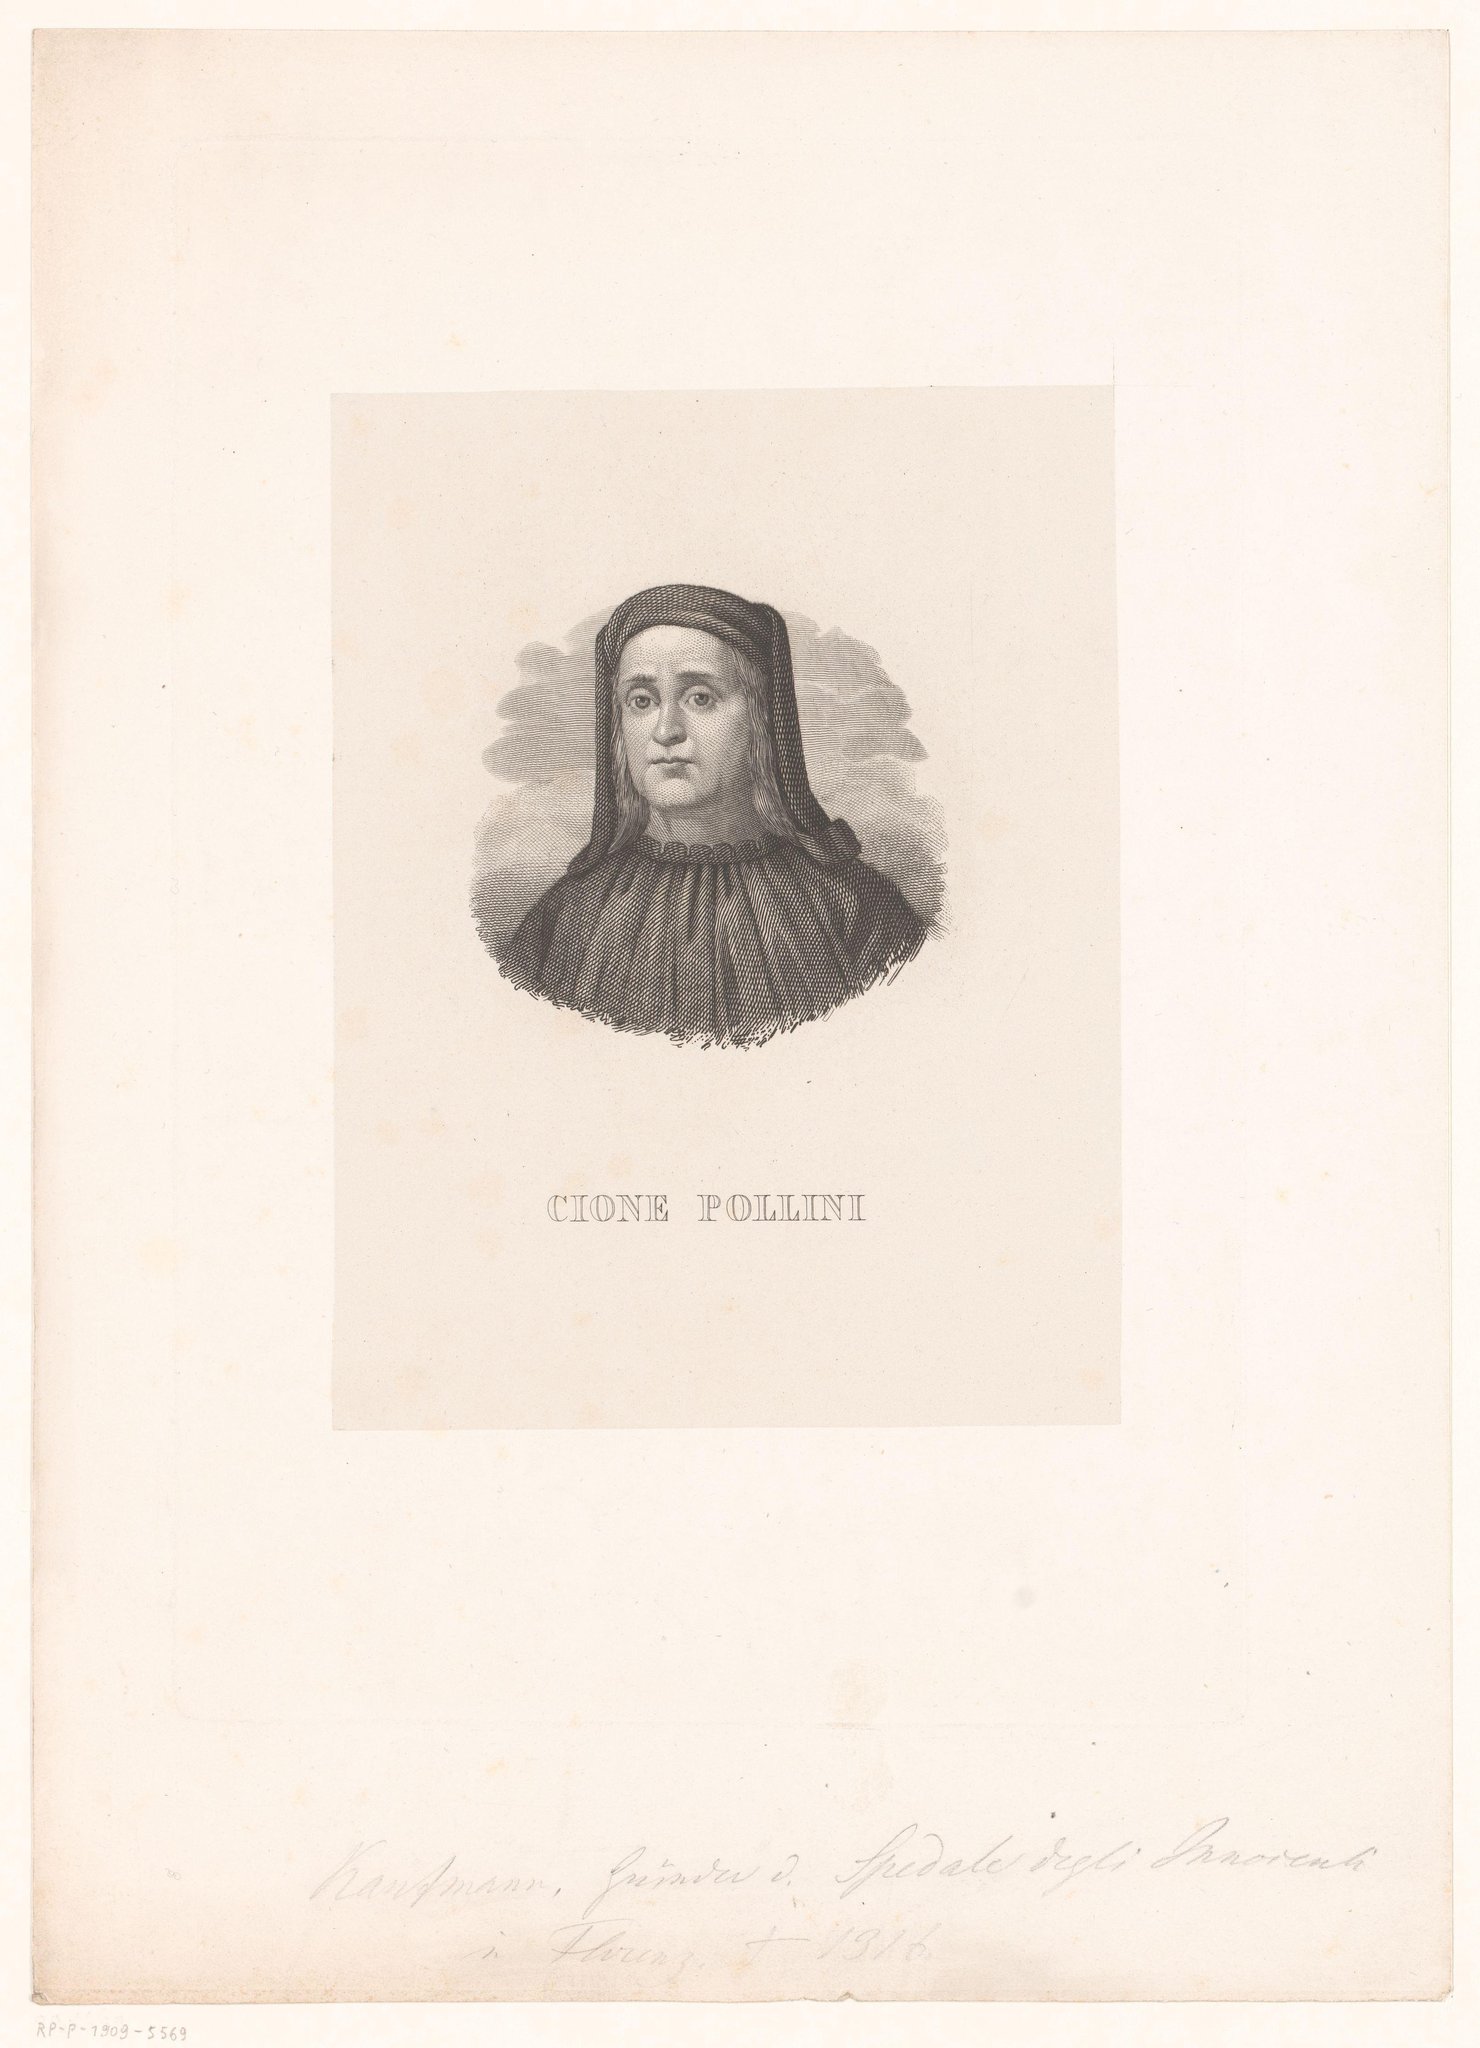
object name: print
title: Portret van Cione Pollini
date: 1741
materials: paper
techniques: engraving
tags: historical persons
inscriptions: collector's mark: Lugt 2228